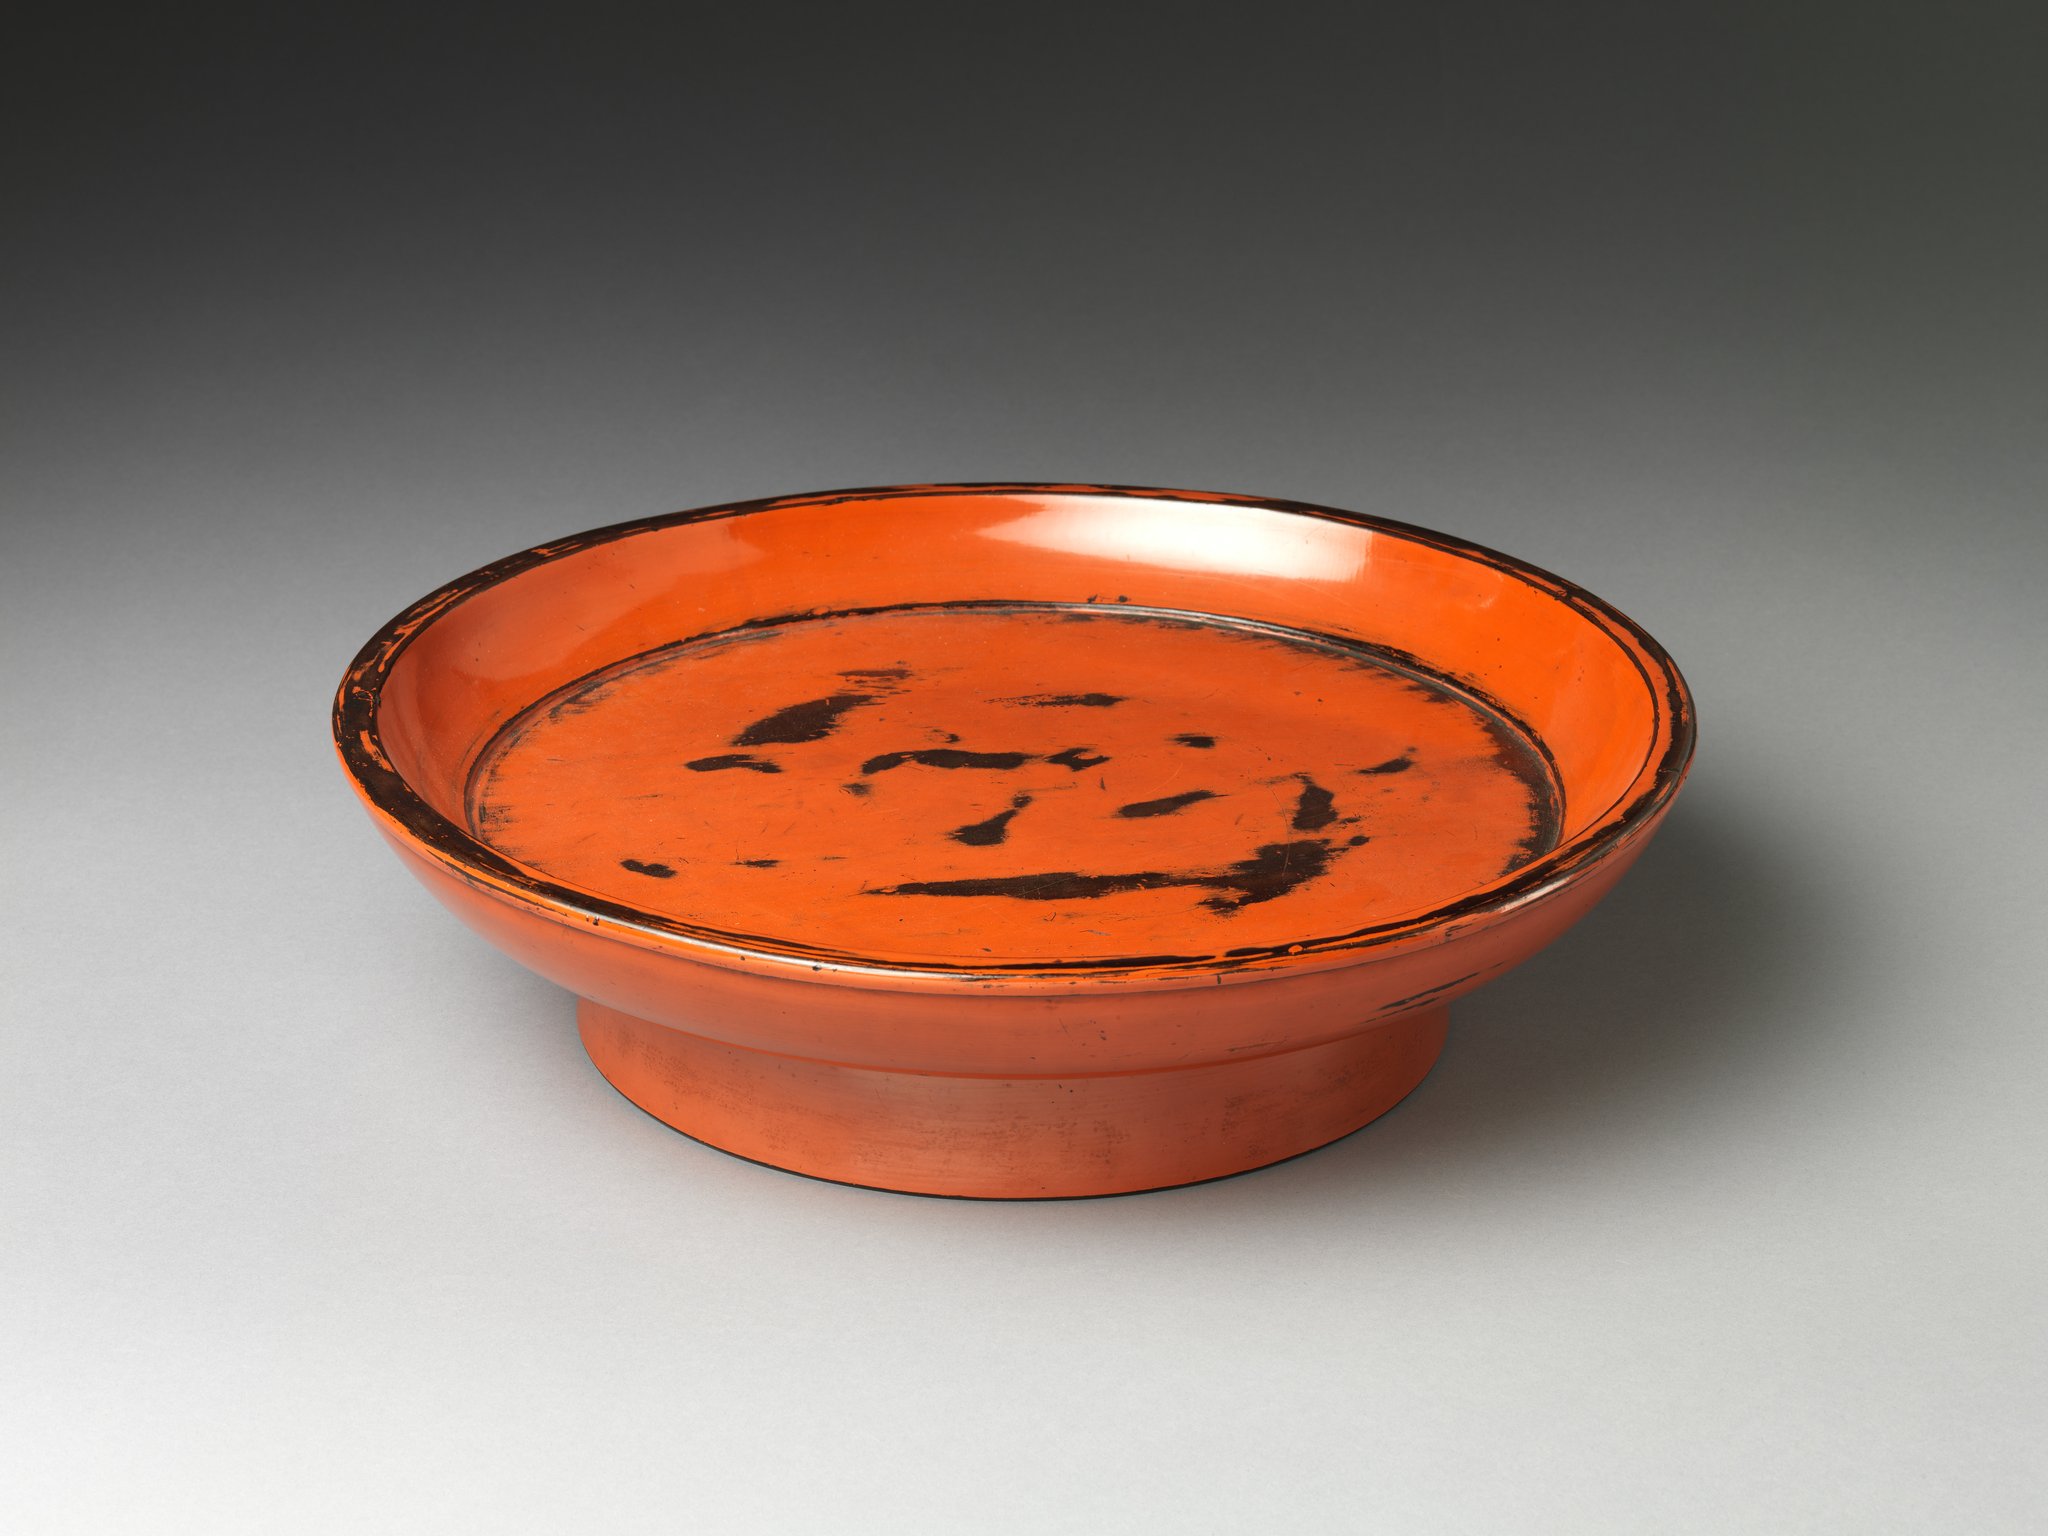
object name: tray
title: Round Negoro Tray (Kōban)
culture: japanese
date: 1401-1450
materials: lacquer, wood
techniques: lacquer